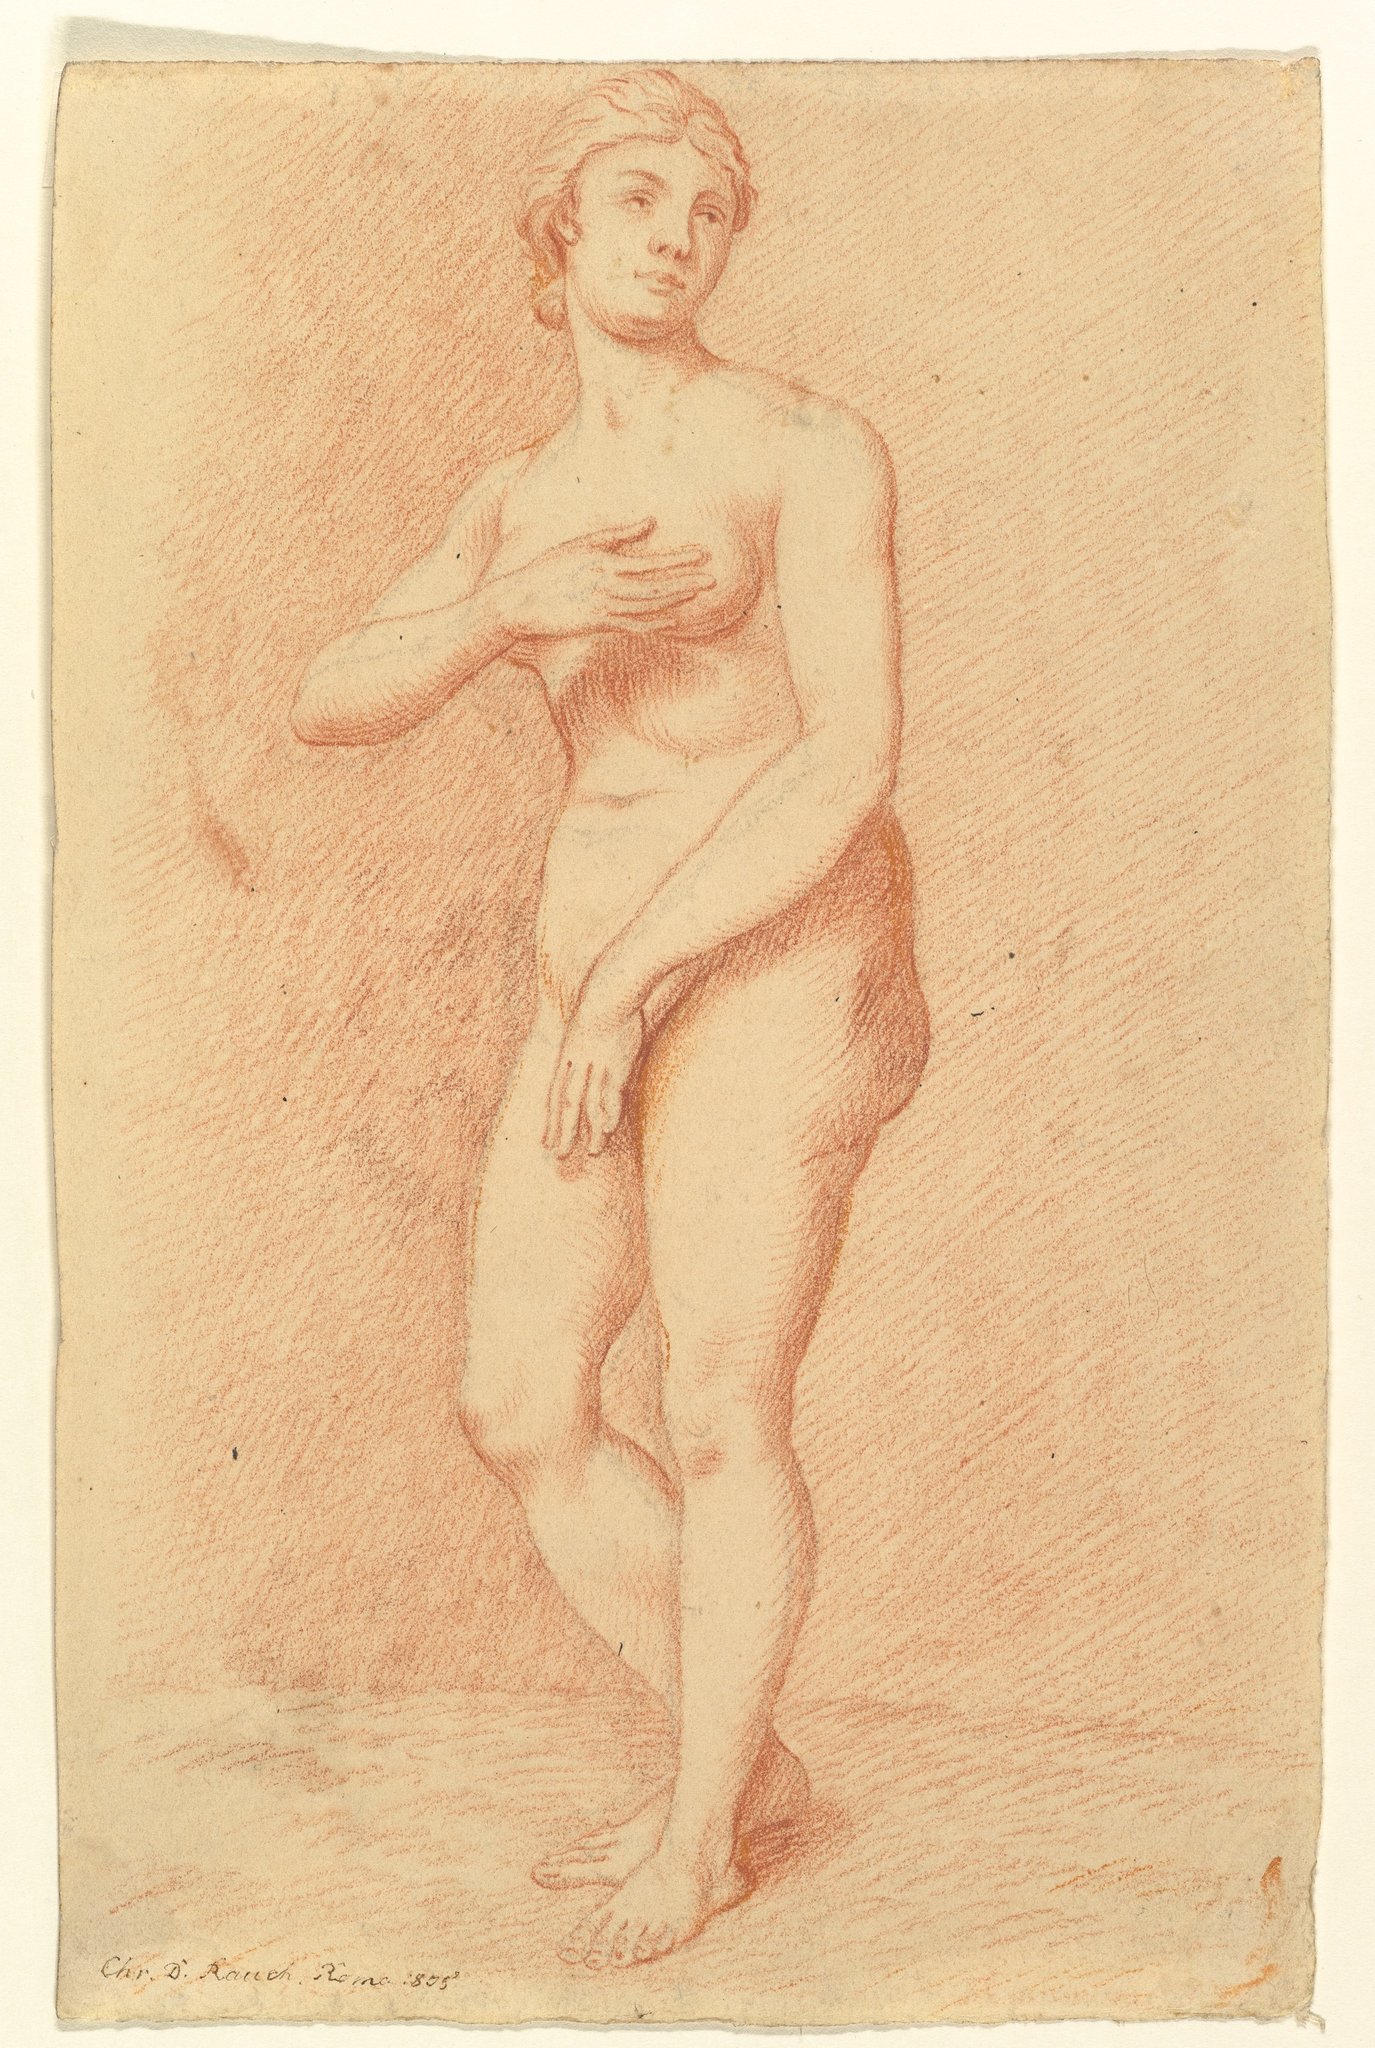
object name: drawing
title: Standing Female Nude (after the Medici Venus)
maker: christian daniel rauch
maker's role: artist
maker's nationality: german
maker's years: 1777-1857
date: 1805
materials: chalk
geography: germany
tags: female nudes